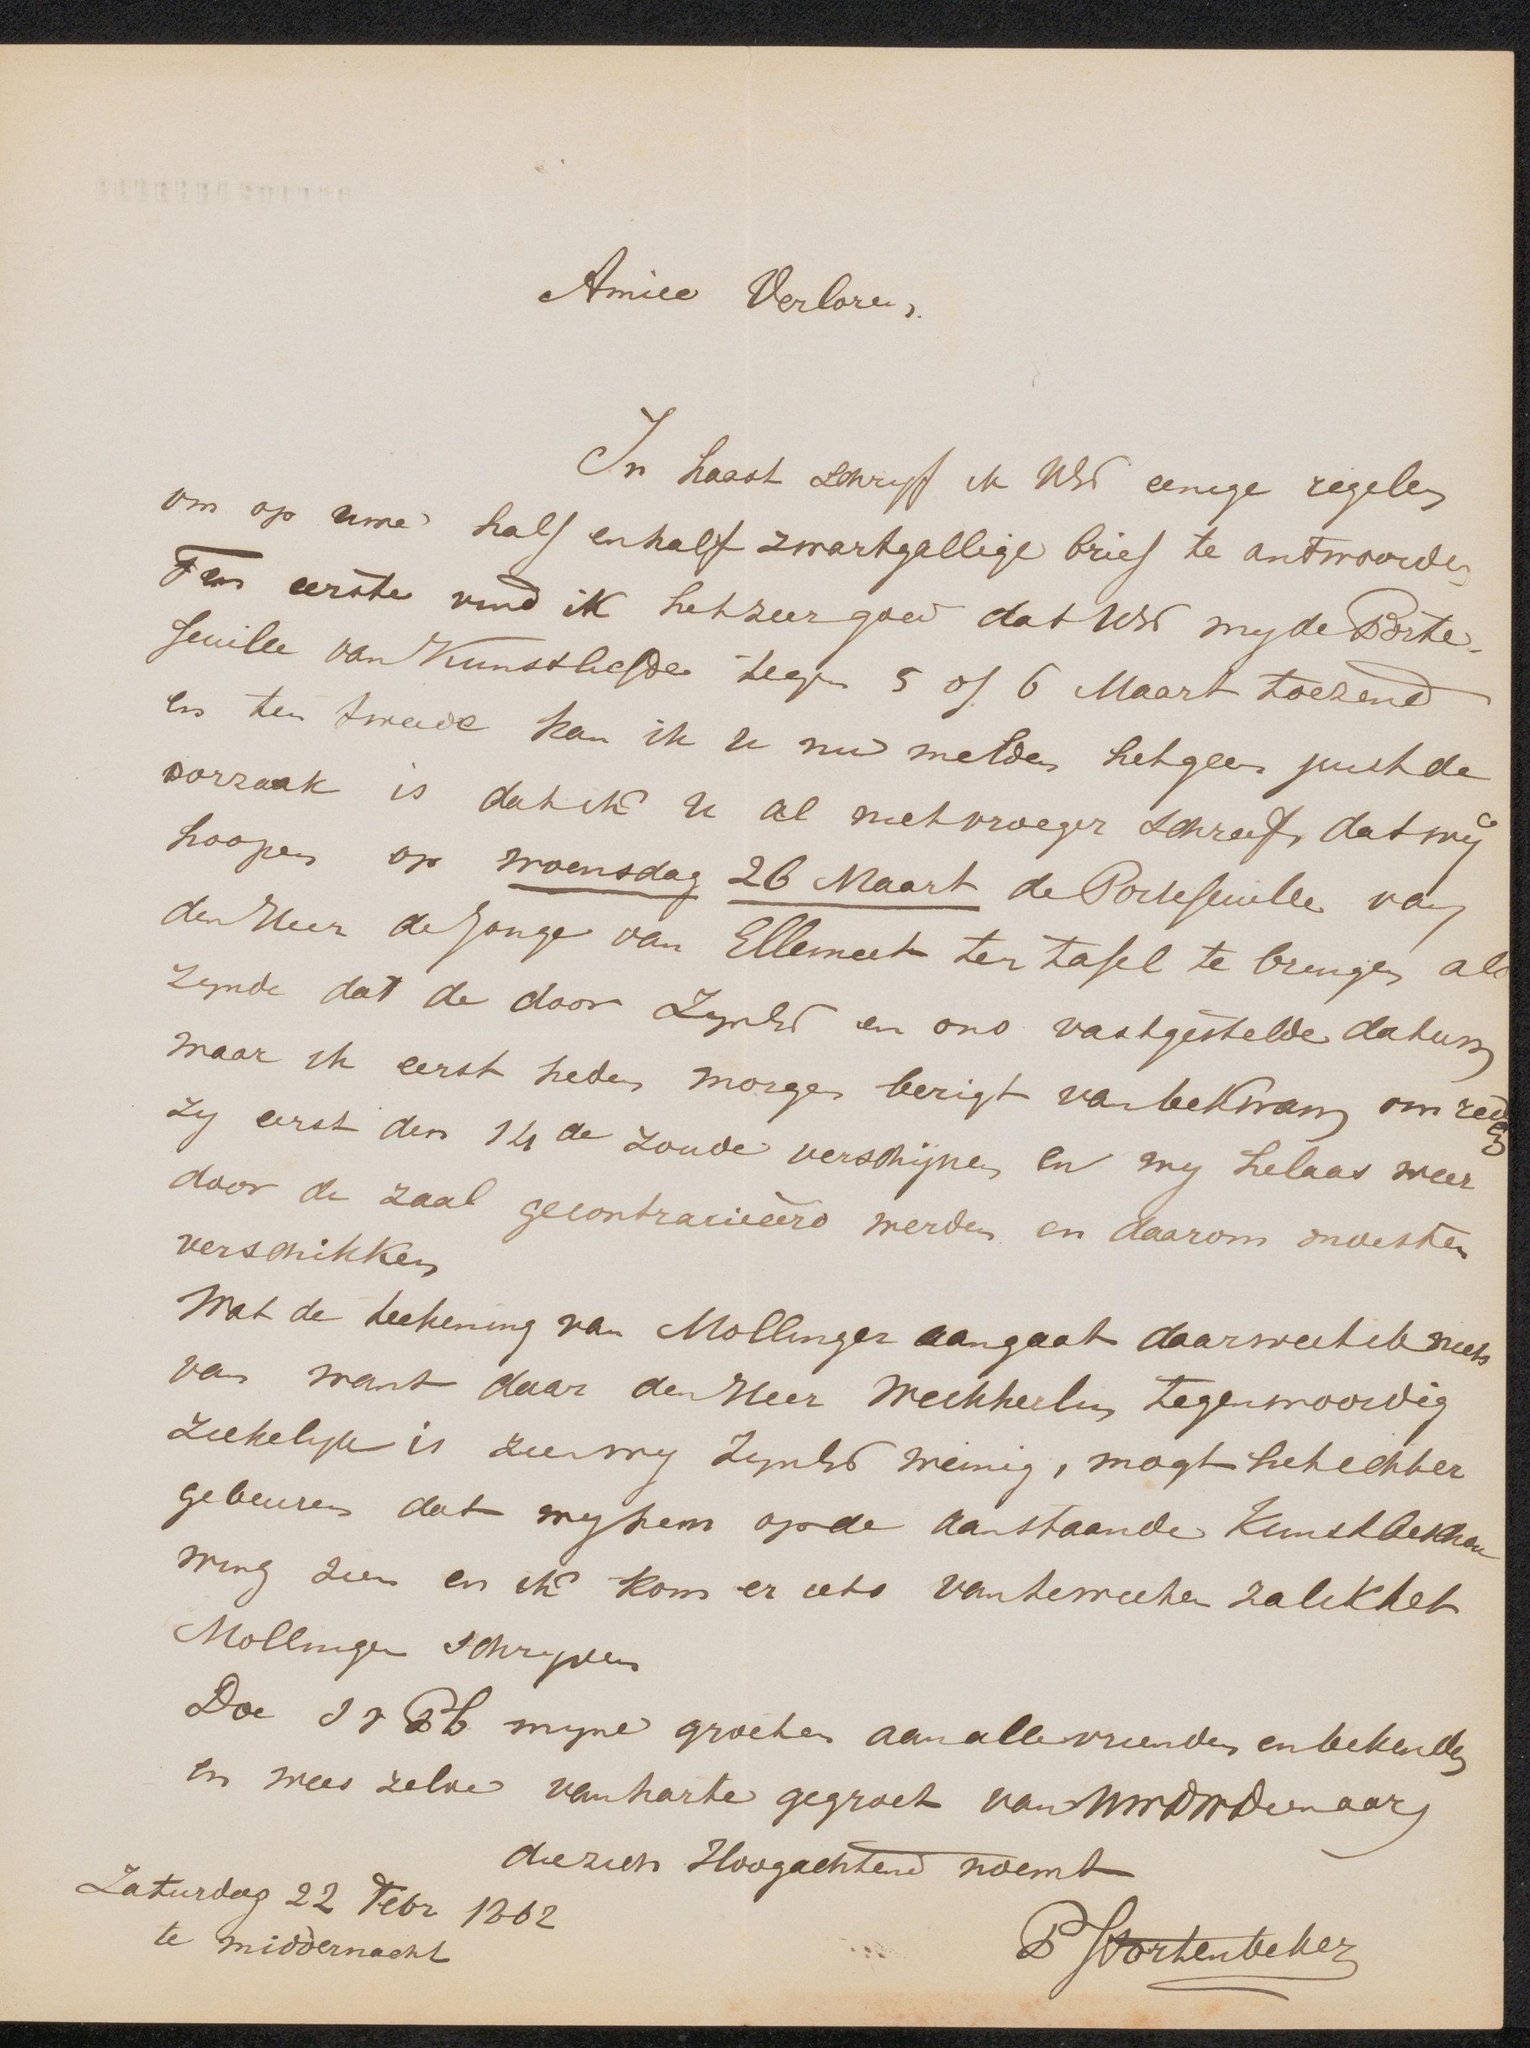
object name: letter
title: Brief aan Pieter Verloren van Themaat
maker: pieter stortenbeker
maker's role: draughtsman, painter, print maker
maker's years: 1828-1898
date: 1862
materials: ink, paper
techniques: pen, writing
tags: utrecht, pieter verloren van themaat, the hague, drawing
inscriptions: collector's mark: ‘RPK’, name: ‘PULCHRI STUDIO’